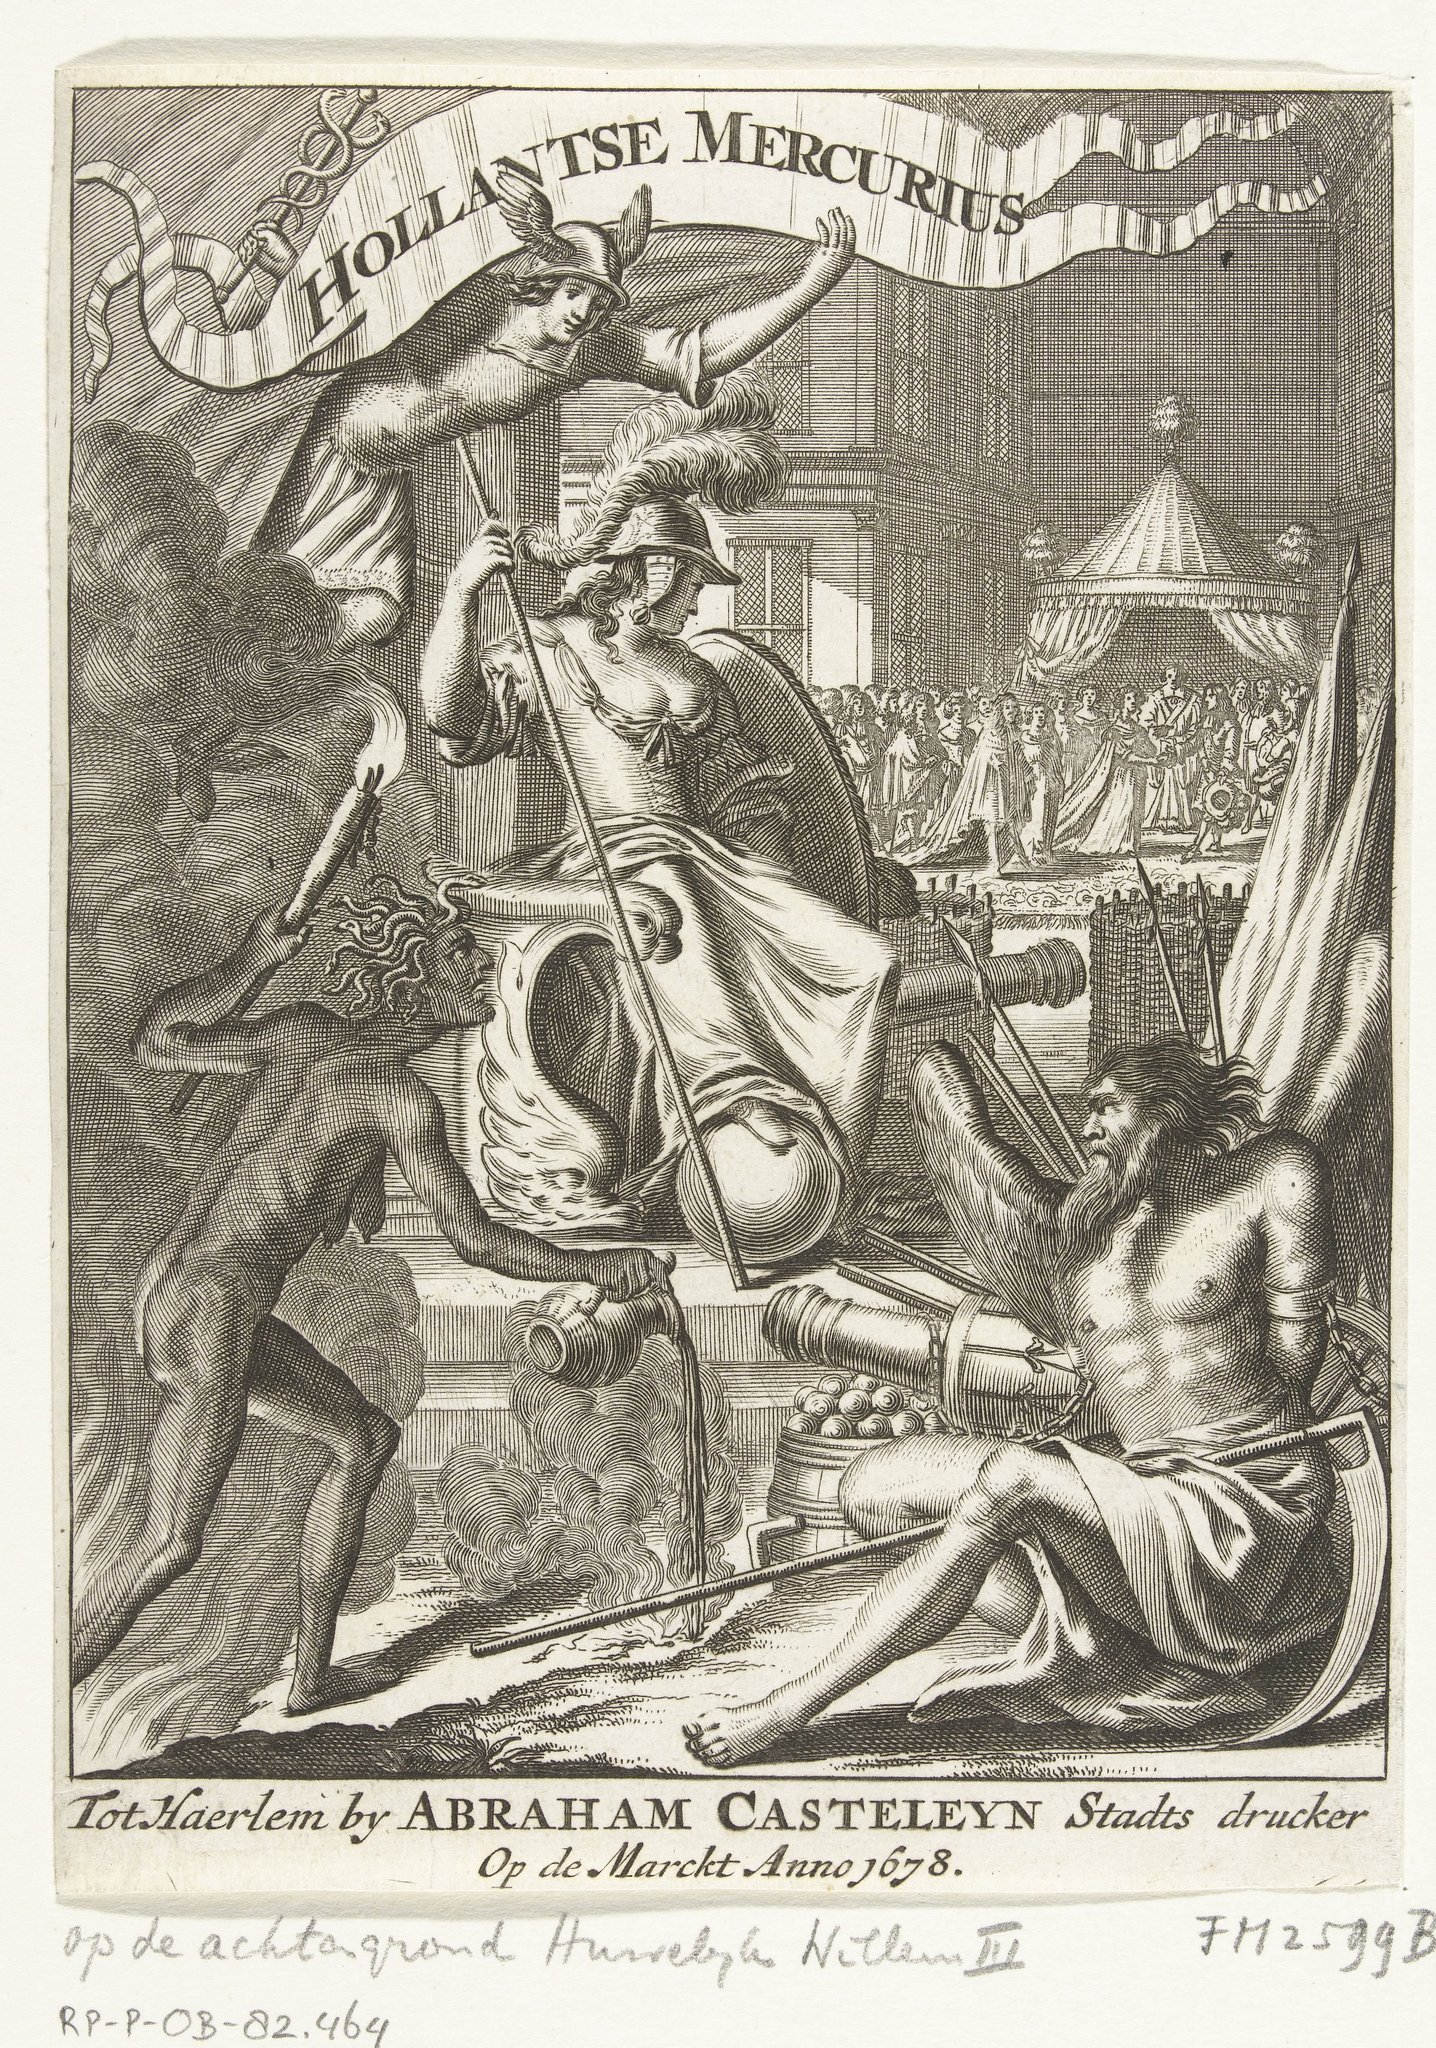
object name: titelblad, titelpagina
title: Titelpagina voor de Hollandsche Mercurius van 1677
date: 1678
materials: paper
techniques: engraving, etching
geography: northern netherlands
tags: the hague, william iii (prince of orange and king of england, scotland, and ireland), london, maria ii stuart (koningin van engeland, schotland en ierland), (civil) marriage ceremonies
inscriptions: date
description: Titelpagina voor de Hollandsche Mercurius van 1677. De Hollandse Maagd zit op haar troon, op de voorgrond giet een furie met fakkel brandende olie op de grond, rechts zit Vader Tijd geboeid. Op de achtergrond het huwelijk van Willem III met Maria Stuart op 4 november 1677 te Londen.